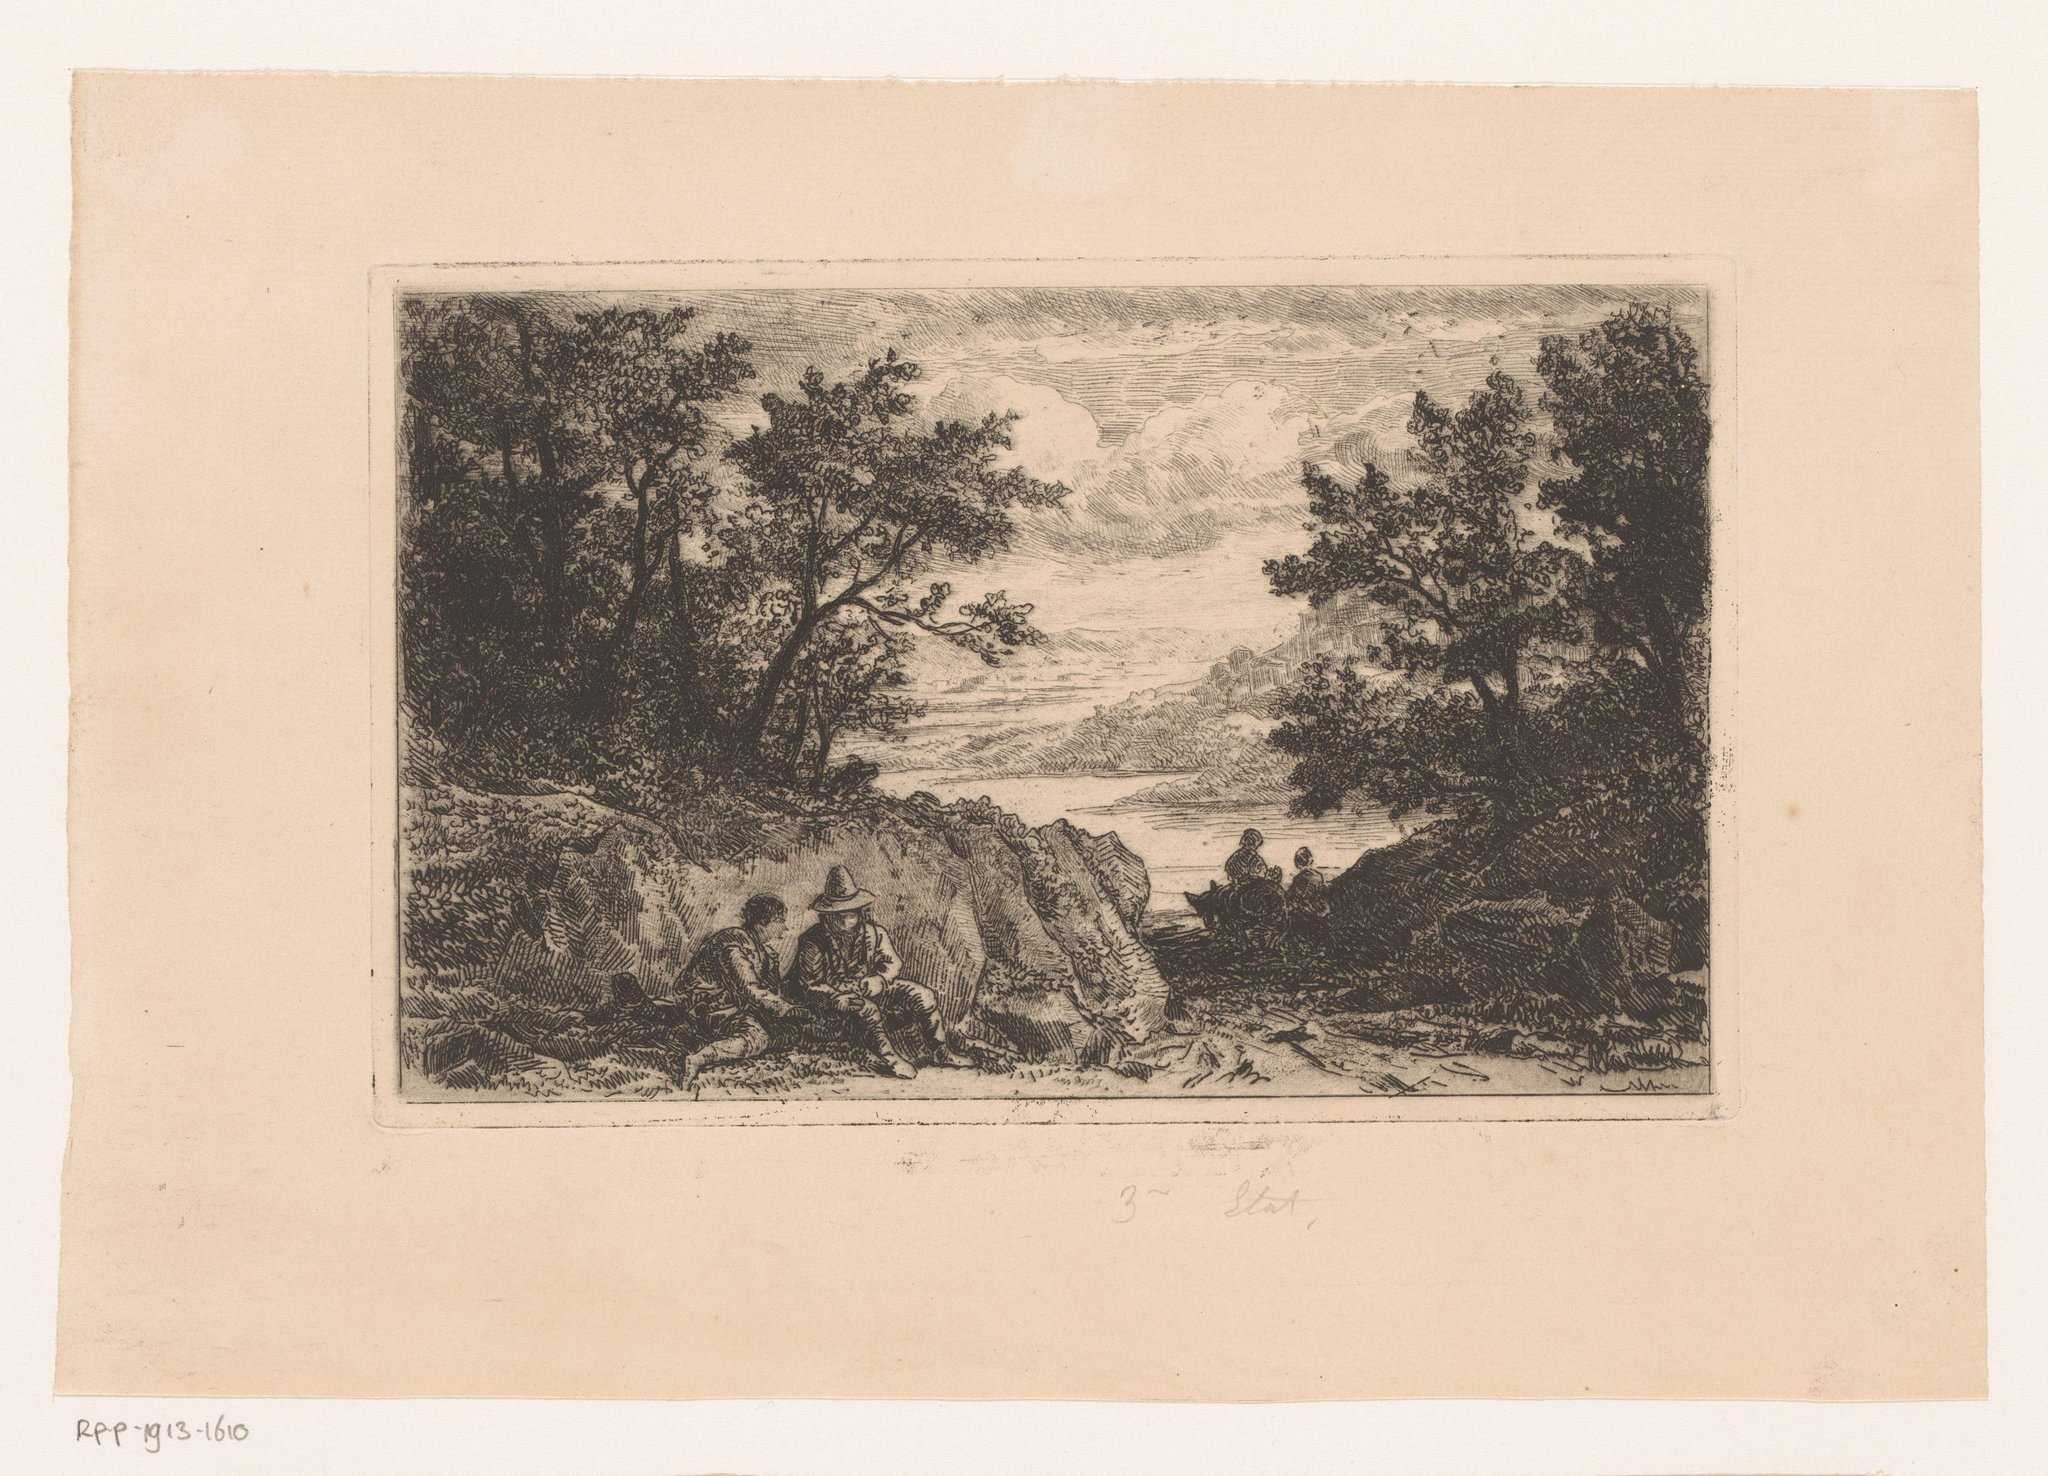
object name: print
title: Gezicht op het meer van Albano en Castel Gandolfo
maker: joseph meganck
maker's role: print maker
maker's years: 1807-1891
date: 1817-1888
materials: paper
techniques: etching, intaglio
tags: riding a horse, ass, or mule; rider, horseman, lake, city-view, and landscape with man-made constructions (+ city(-scape) with figures, staffage)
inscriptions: collector's mark: Lugt 2228, inscription: ‘3e Etat’